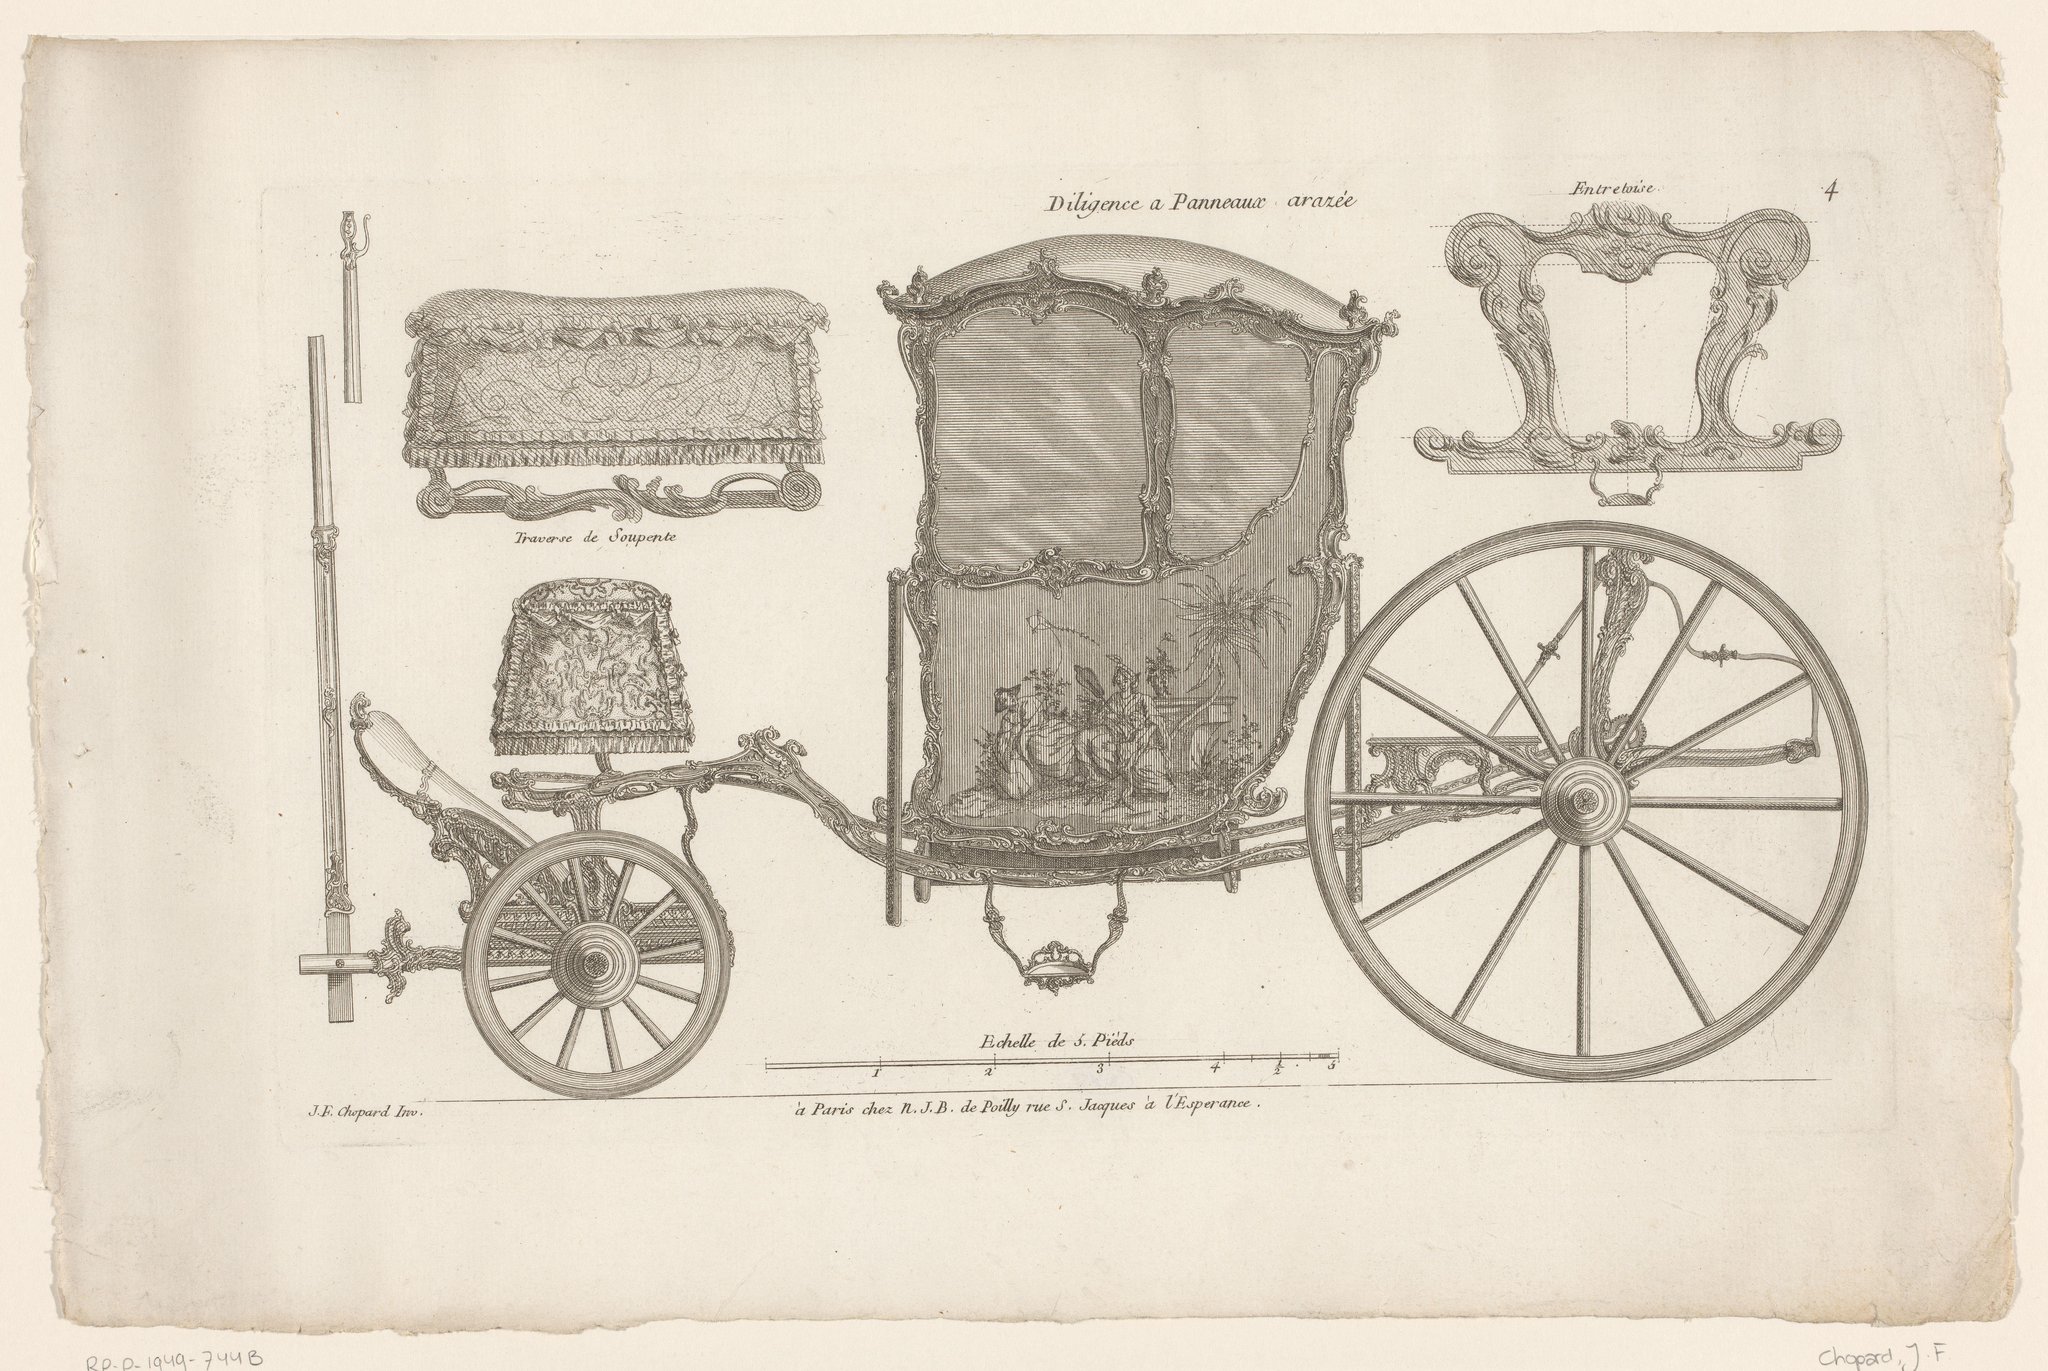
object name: ornament print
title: Modèles de voitures Louis XV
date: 1740-1758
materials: paper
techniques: engraving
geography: paris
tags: four-wheeled, animal-drawn vehicle, e.g.: cab, carriage, coach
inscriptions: collector's mark: Lugt 2228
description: Diligence met afbeelding van vliegerende vrouwen. Een diligence is een gesloten Franse passagiers- en postkoets.